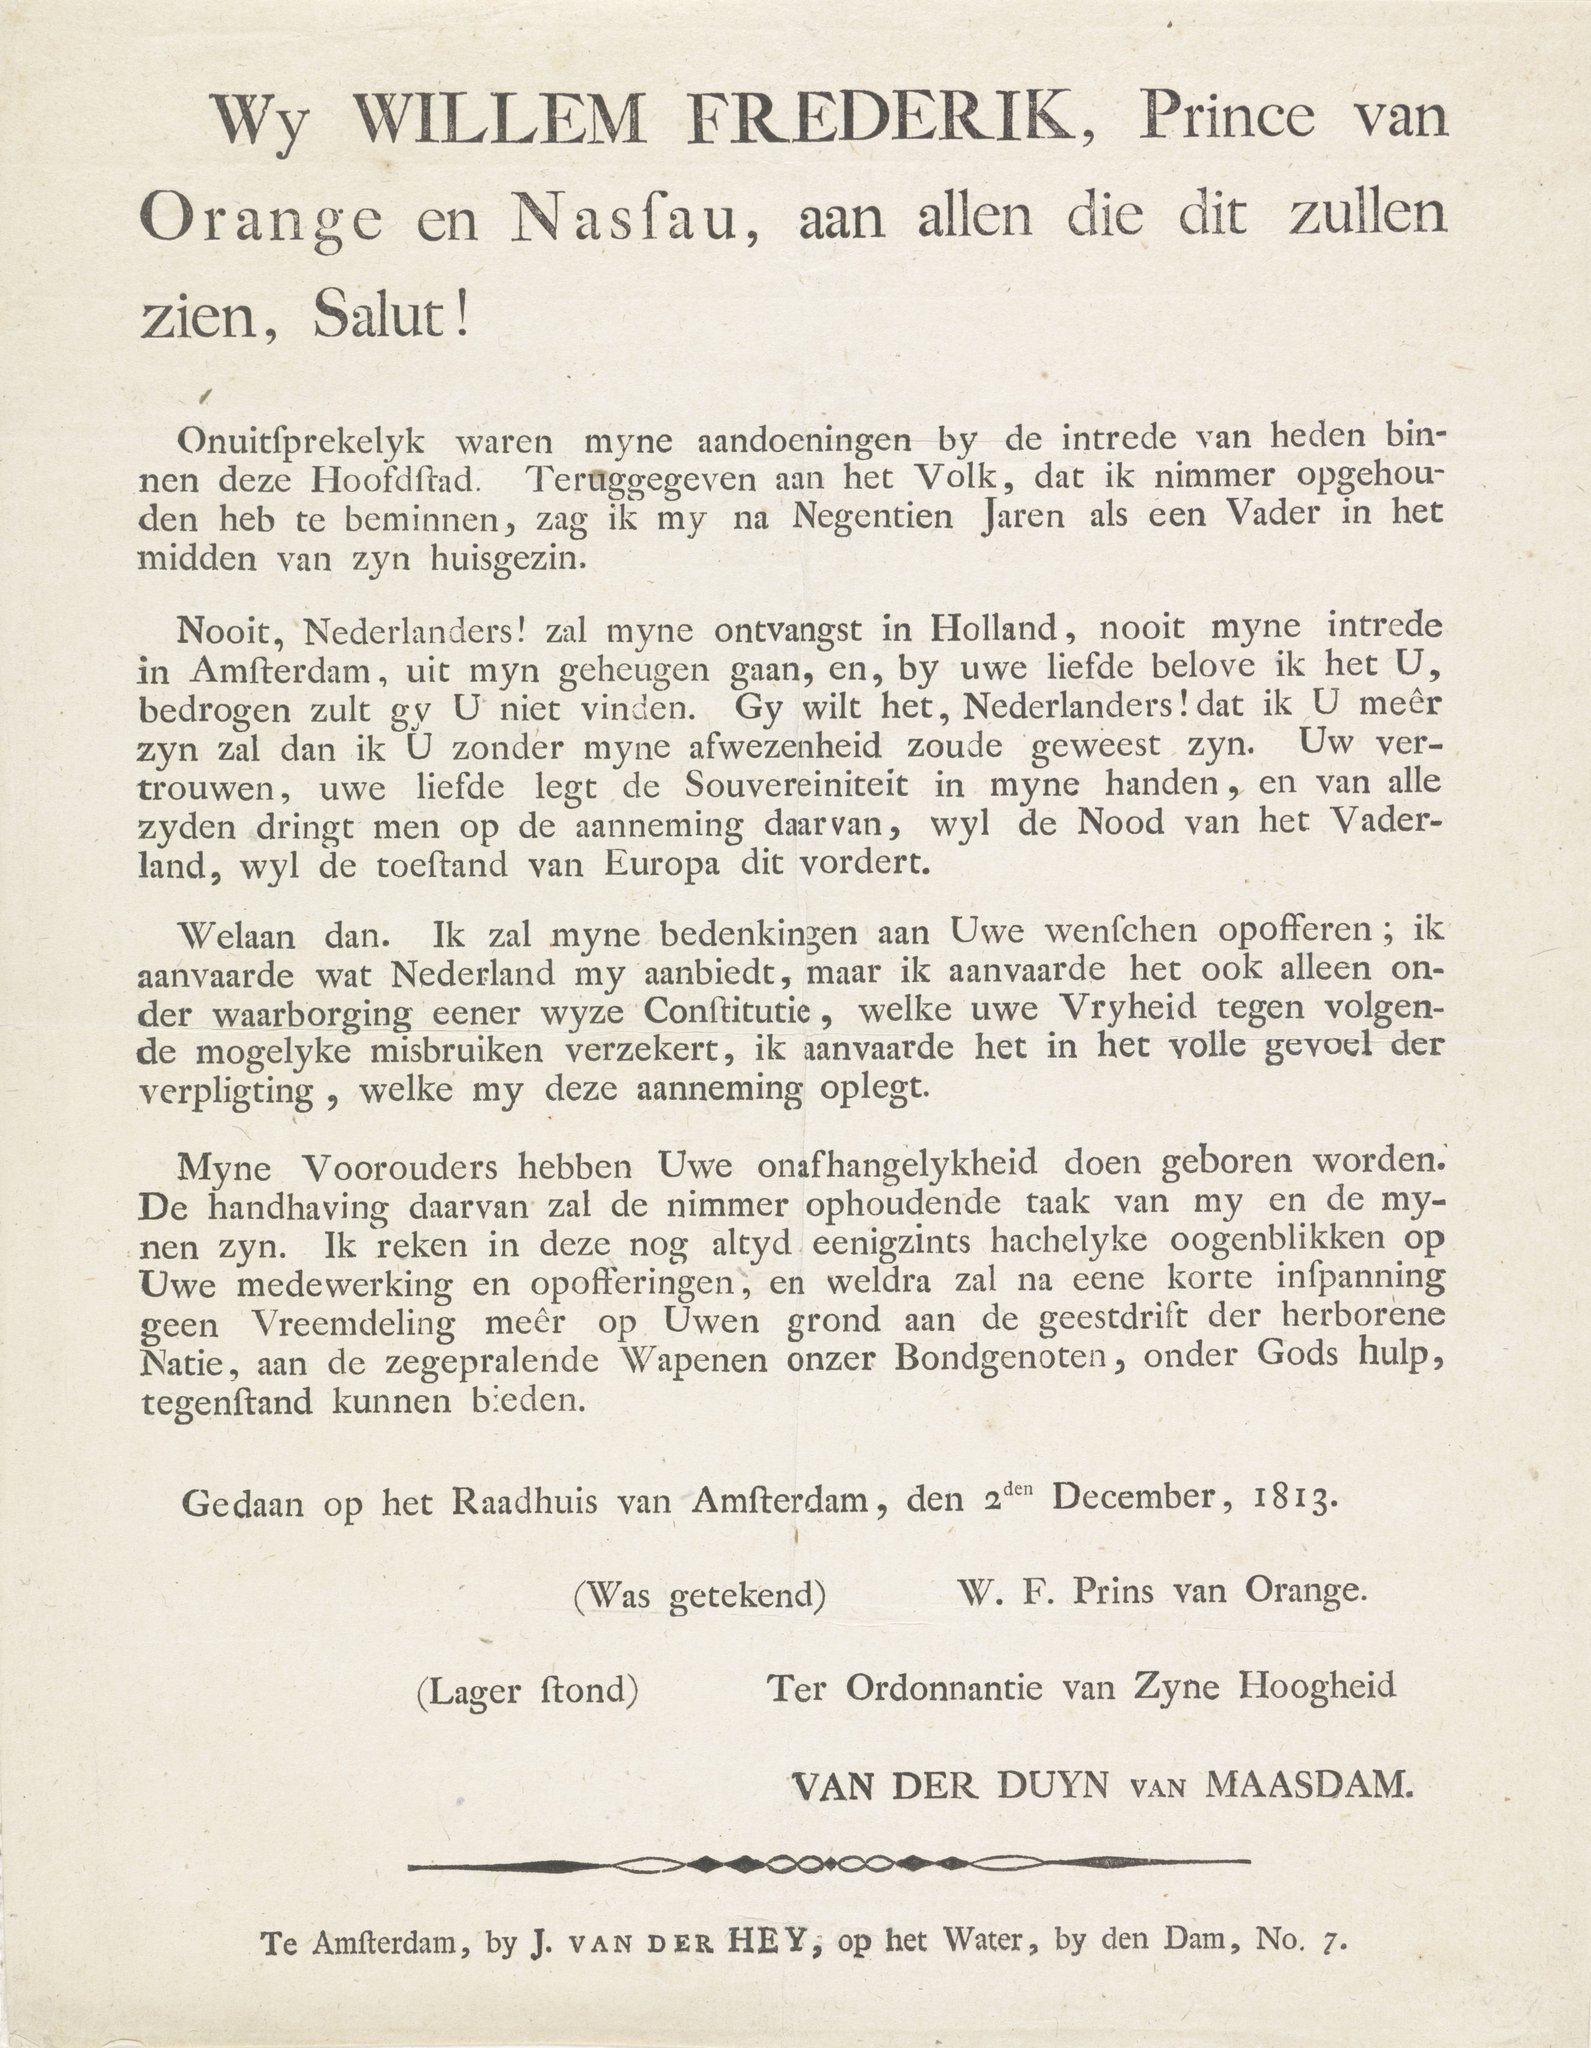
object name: proclamation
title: Wy Willem Frederik, Prince van Orange en Nassau, aan allen die dit zullen zien, Salut!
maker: johannes van der hey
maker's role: publisher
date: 1813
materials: paper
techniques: letterpress printing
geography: amsterdam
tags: amsterdam, landing of william frederick i (1813)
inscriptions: collector's mark: Lugt 2228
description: Proclamatie vanwege de prins van Oranje bij zijn intrede als soeverein vorst in Amsterdam, 2 december 1813. Ook namens Van der Duyn van Maasdam.